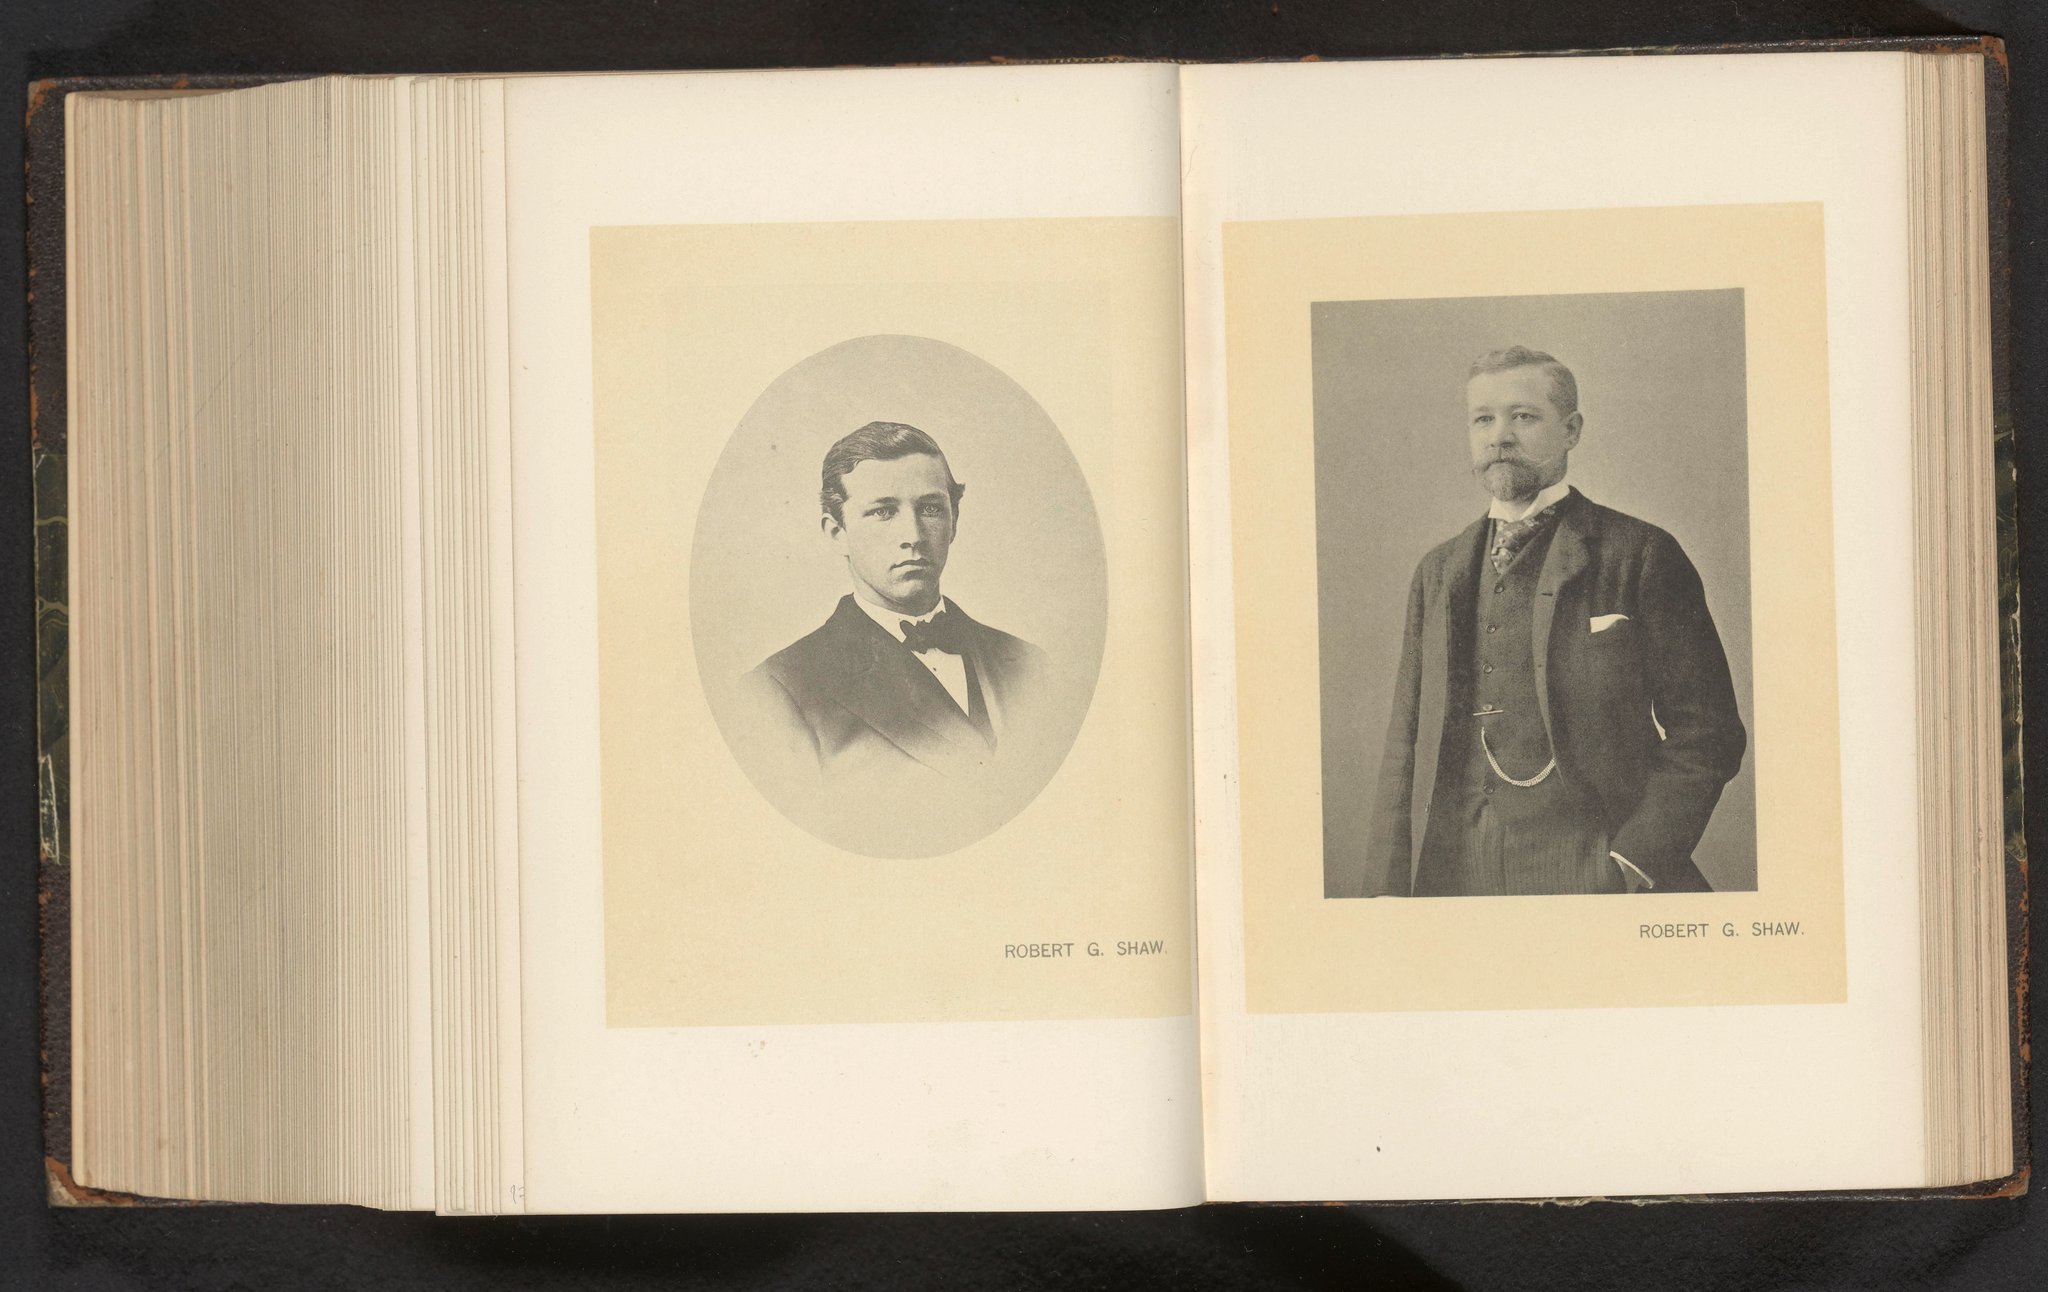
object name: photomechanical print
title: Robert G. Shaw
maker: Anonymous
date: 1869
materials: paper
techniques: photoaquatint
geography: boston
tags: adult man